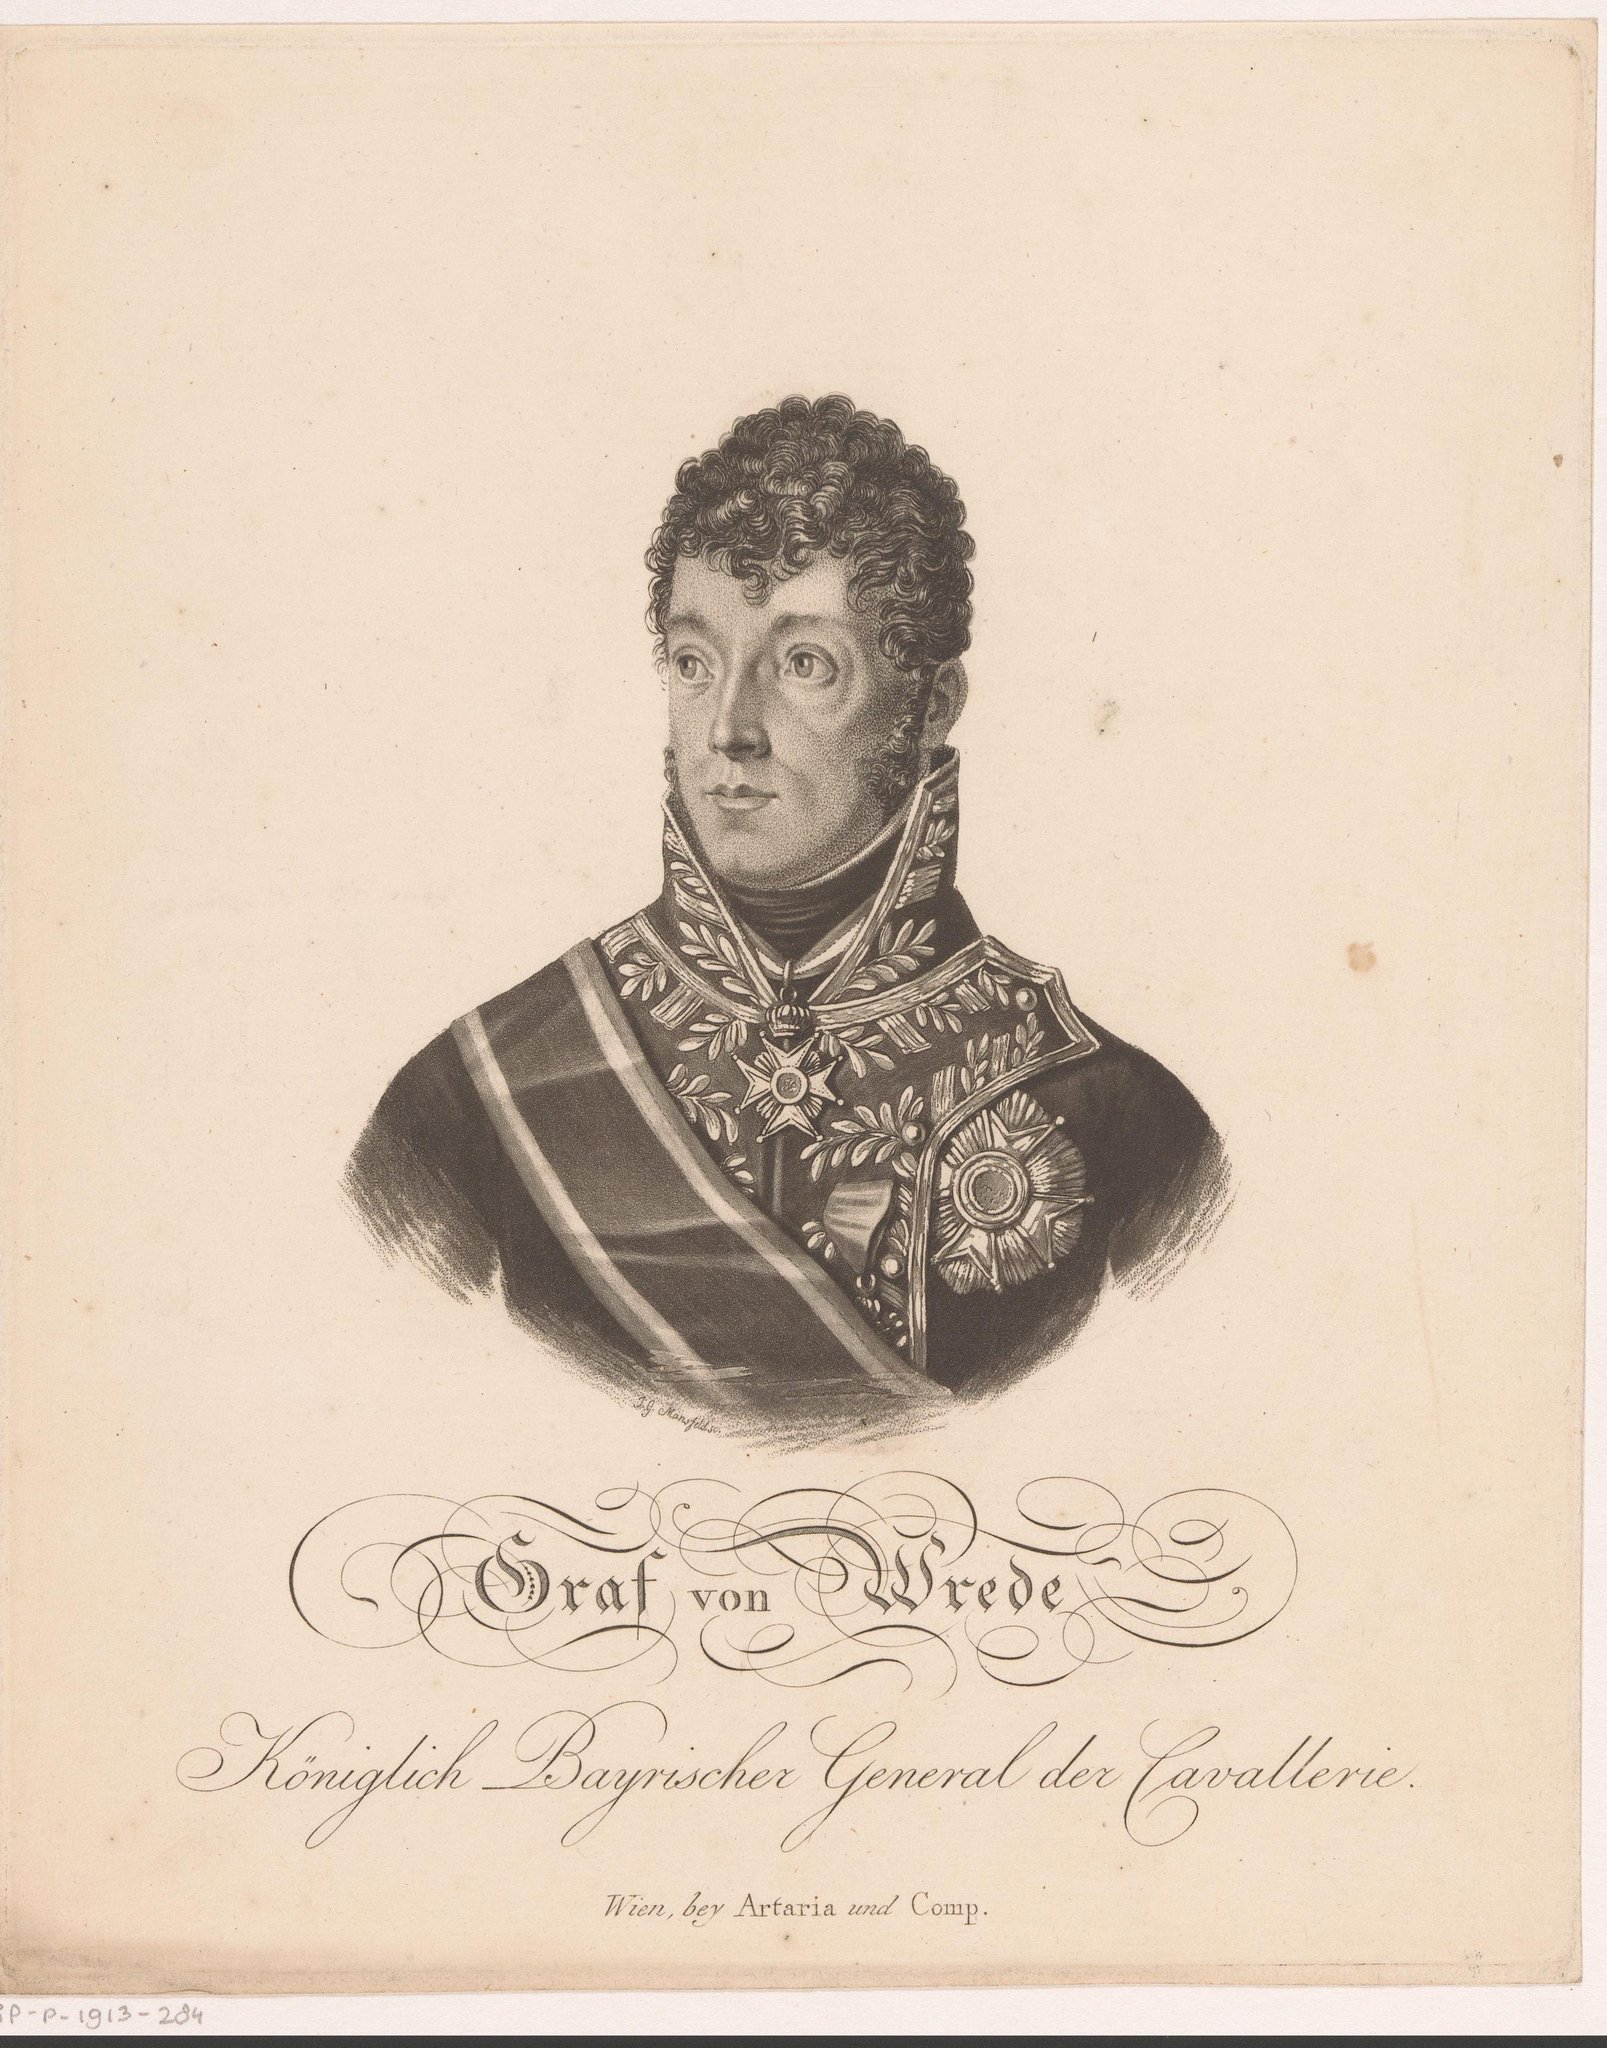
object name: print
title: Portret van Carl Philipp von Wrede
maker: johann georg mannsfeld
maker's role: print maker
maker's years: 1764-1817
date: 1774-1817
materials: paper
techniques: aquatint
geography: vienna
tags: historical persons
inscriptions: collector's mark: Lugt 2228